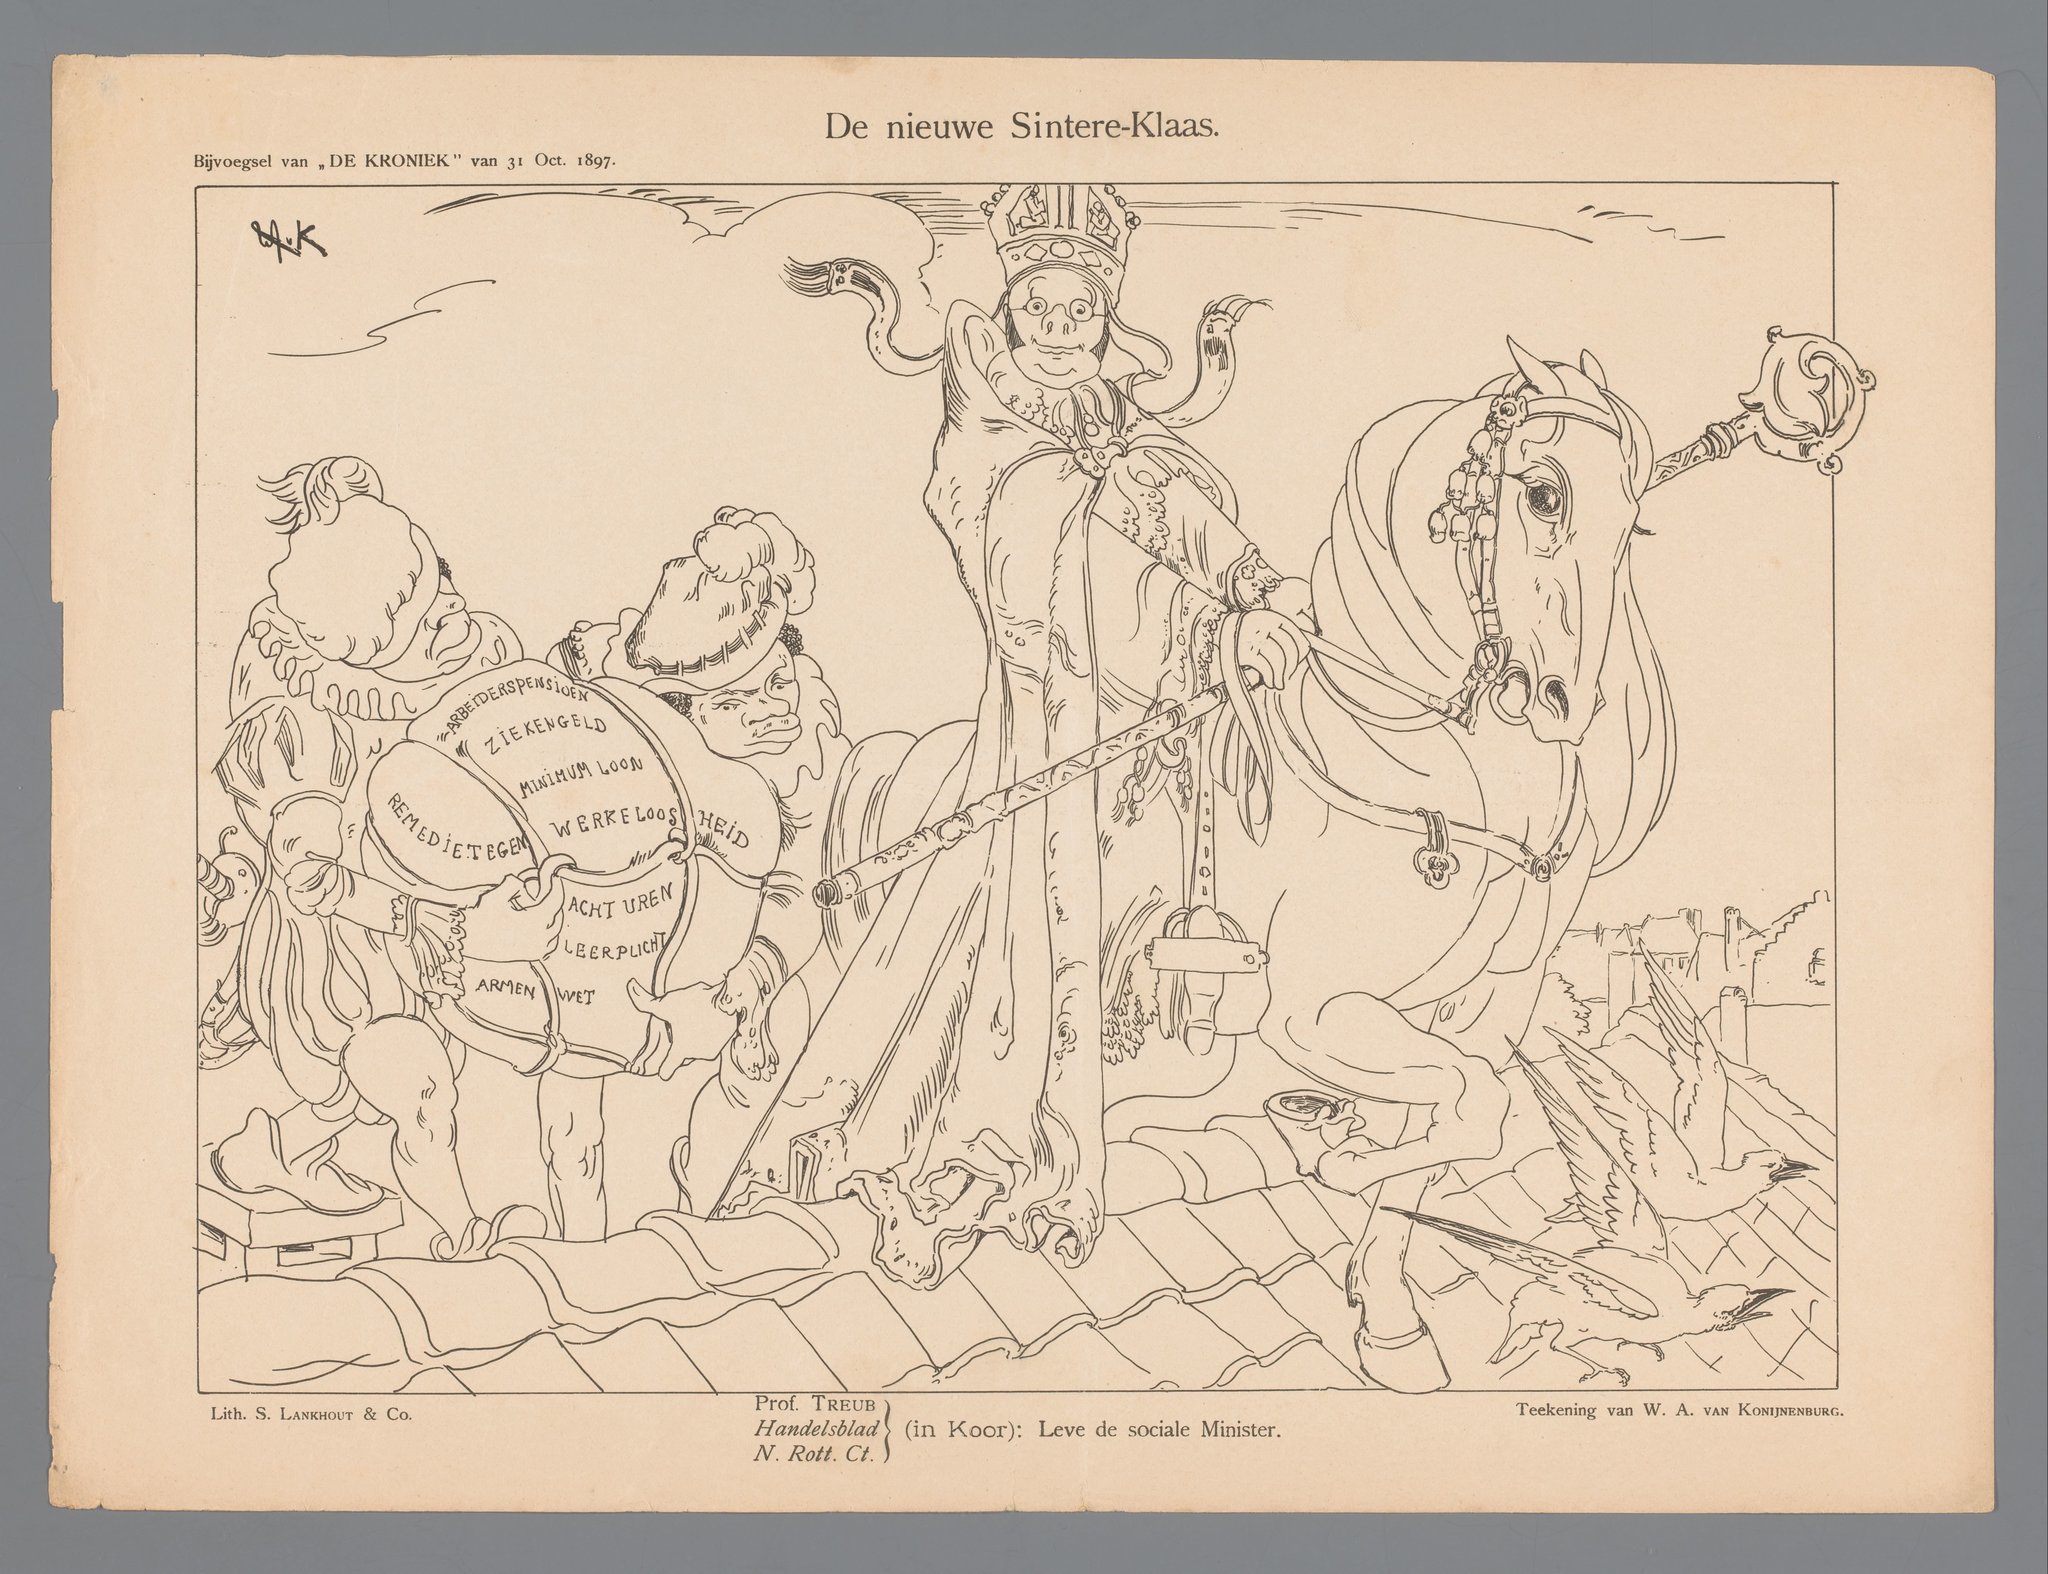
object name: cartoon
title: De nieuwe Sintere-Klaas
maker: willem van konijnenburg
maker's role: draughtsman, painter, print maker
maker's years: 1868-1943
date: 1897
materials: paper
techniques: lithograph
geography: the hague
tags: nicolaas gerard pierson, voorschoten, politician, e.g. party leader, festivities on st. nicholas (eve) (december 5), political caricatures and satires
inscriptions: date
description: Prent uit het bijvoegsel van: De Kroniek 3 (1897), 31 oktober 1897.